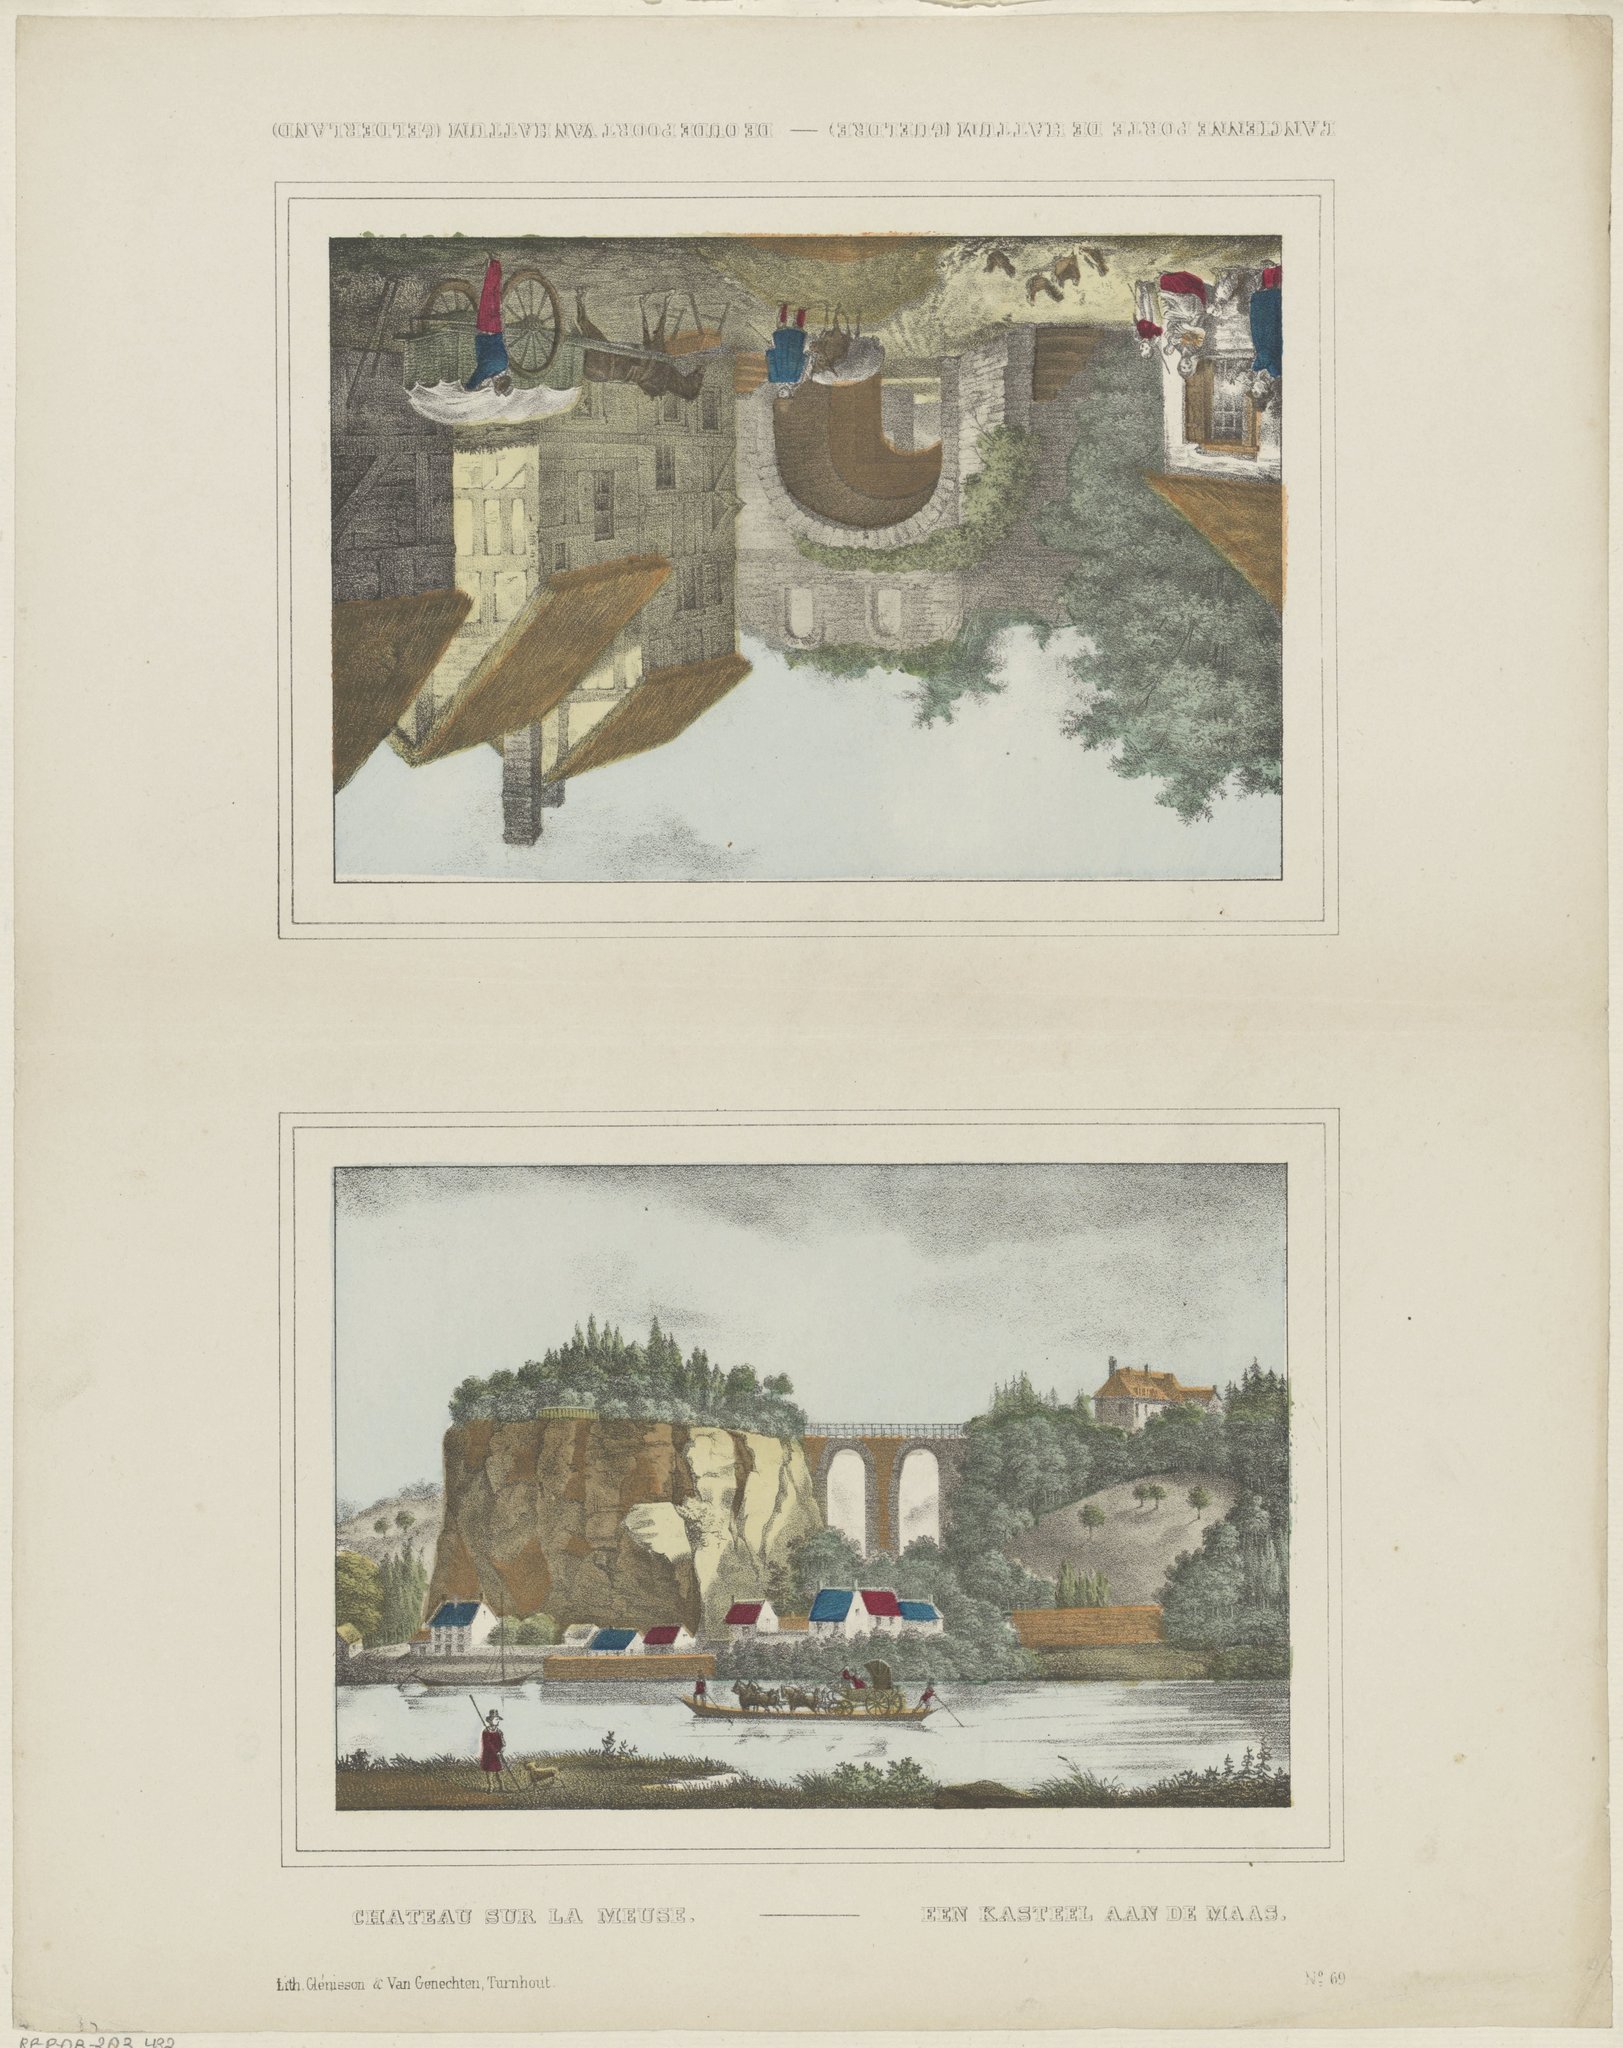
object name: popular print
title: L'ancienne porte de Hattum (Gueldre) / De oude poort van Hattum (Gelderland) / Chateau sur la Meuse / Een kasteel aan de Maas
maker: Anonymous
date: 1833-1856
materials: paper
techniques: colour, letterpress printing, lithograph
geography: turnhout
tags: river bank - hh - ideal landscapes, castle, village-gate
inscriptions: collector's mark: Lugt 2760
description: Blad met 2 voorstellingen. Boven (ondersteboven) de oude poort (mogelijk de Dijkpoort) te Hattem, onder een kasteel aan de Maas. Onder de voorstellingen de titels. Genummerd rechtsonder: No. 69.